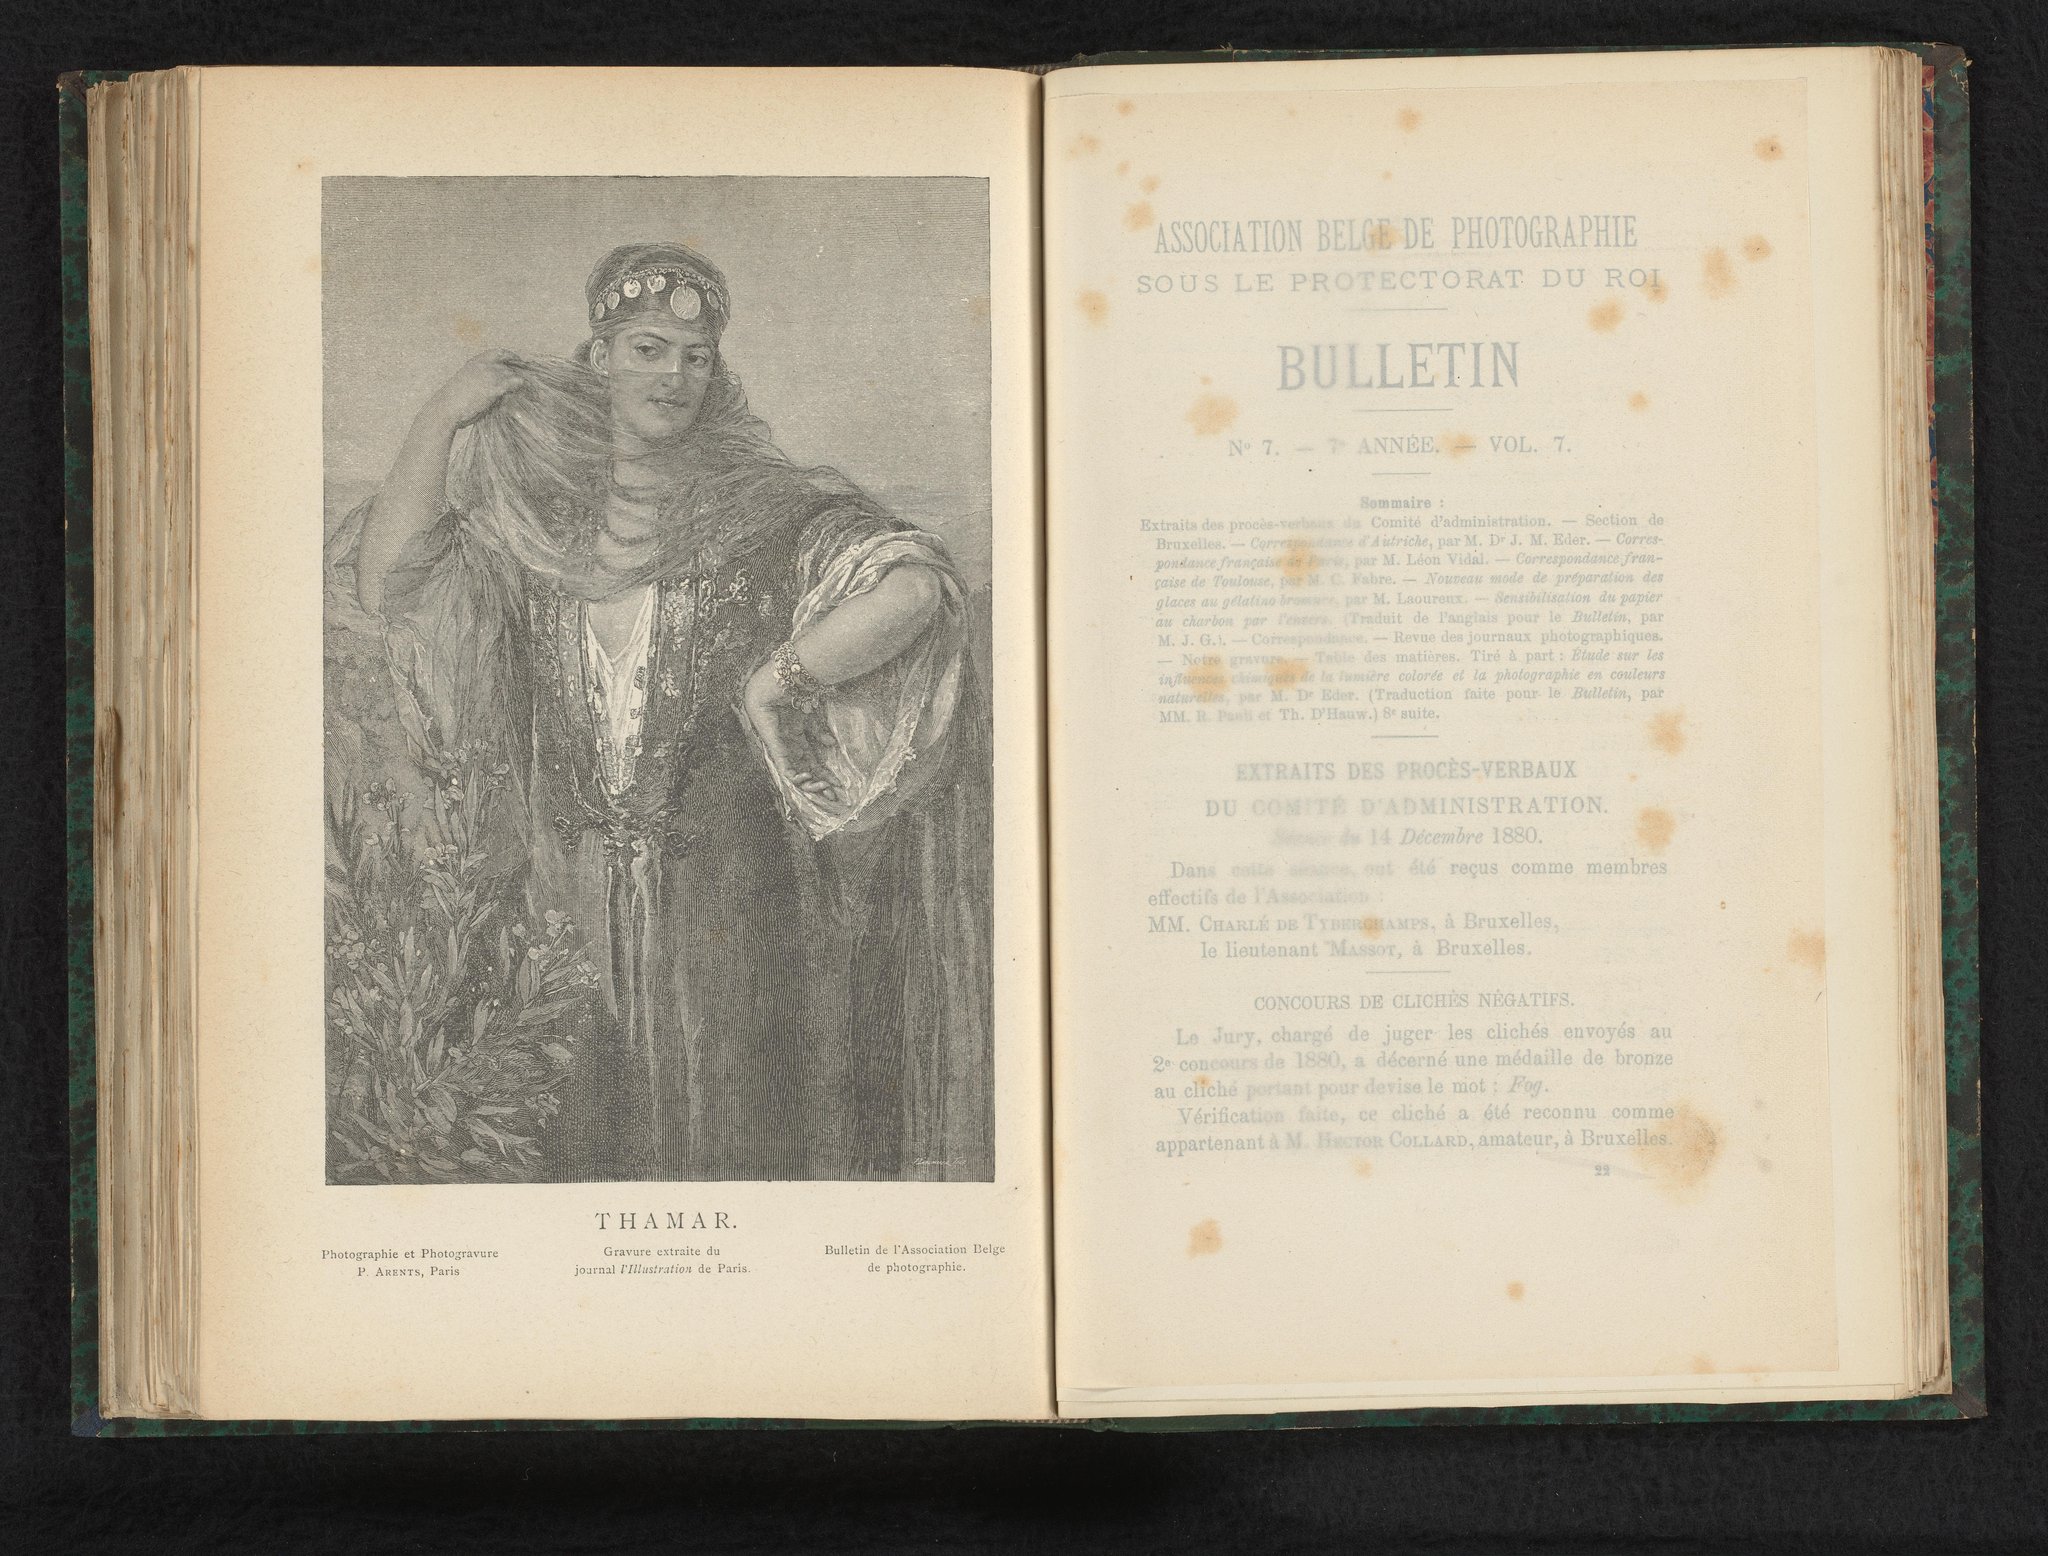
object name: page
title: Reproductie van een gravure van Thamar met een sluier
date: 1880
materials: paper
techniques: photoaquatint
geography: ghent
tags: historical persons not known by name - bb - woman, veil, tamar changes from her widow's clothes and covers her face with a veil after the manner of the prostitutes; sitting at the entrance of a city on the road to timnath she awaits judah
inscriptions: inscription: ‘Gravure extraite du/ journal l'Illustration de Paris.’